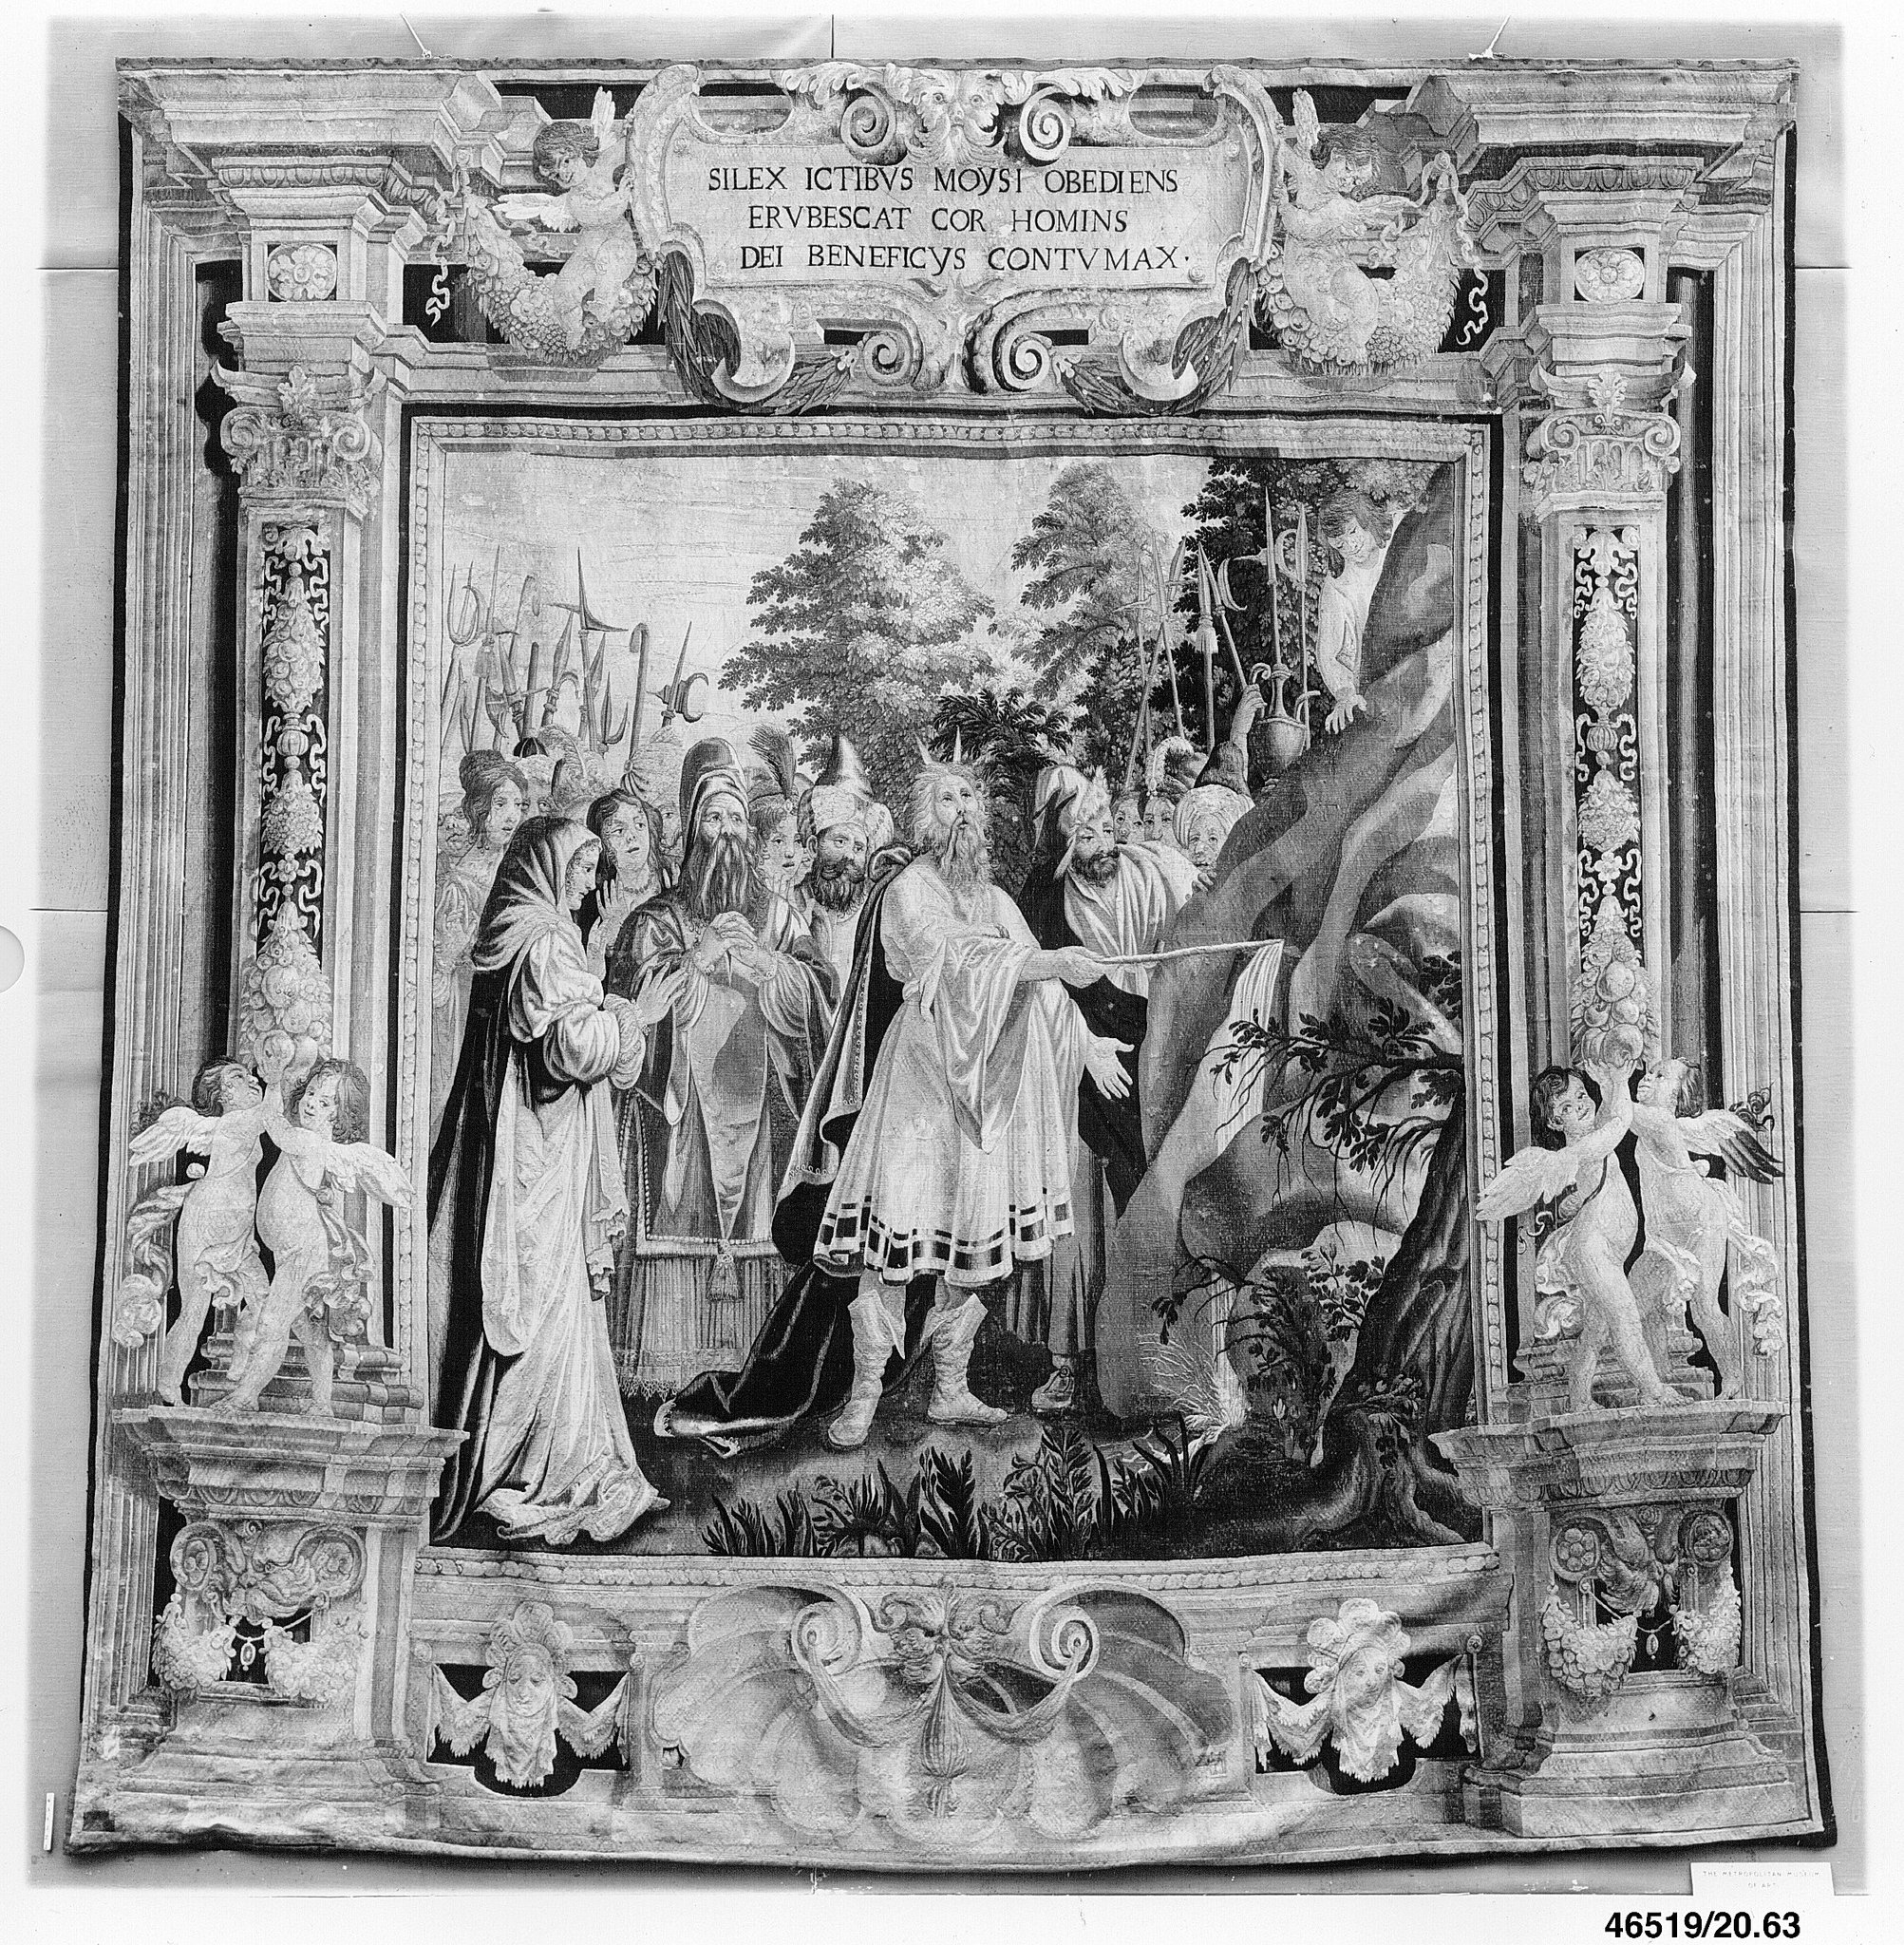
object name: tapestry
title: Moses Striking the Rock from a set of the Life of Moses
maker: agostino melissi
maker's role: designer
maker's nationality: italian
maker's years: 1615-1683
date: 1650-1657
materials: silk, wool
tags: men,women,putti,moses